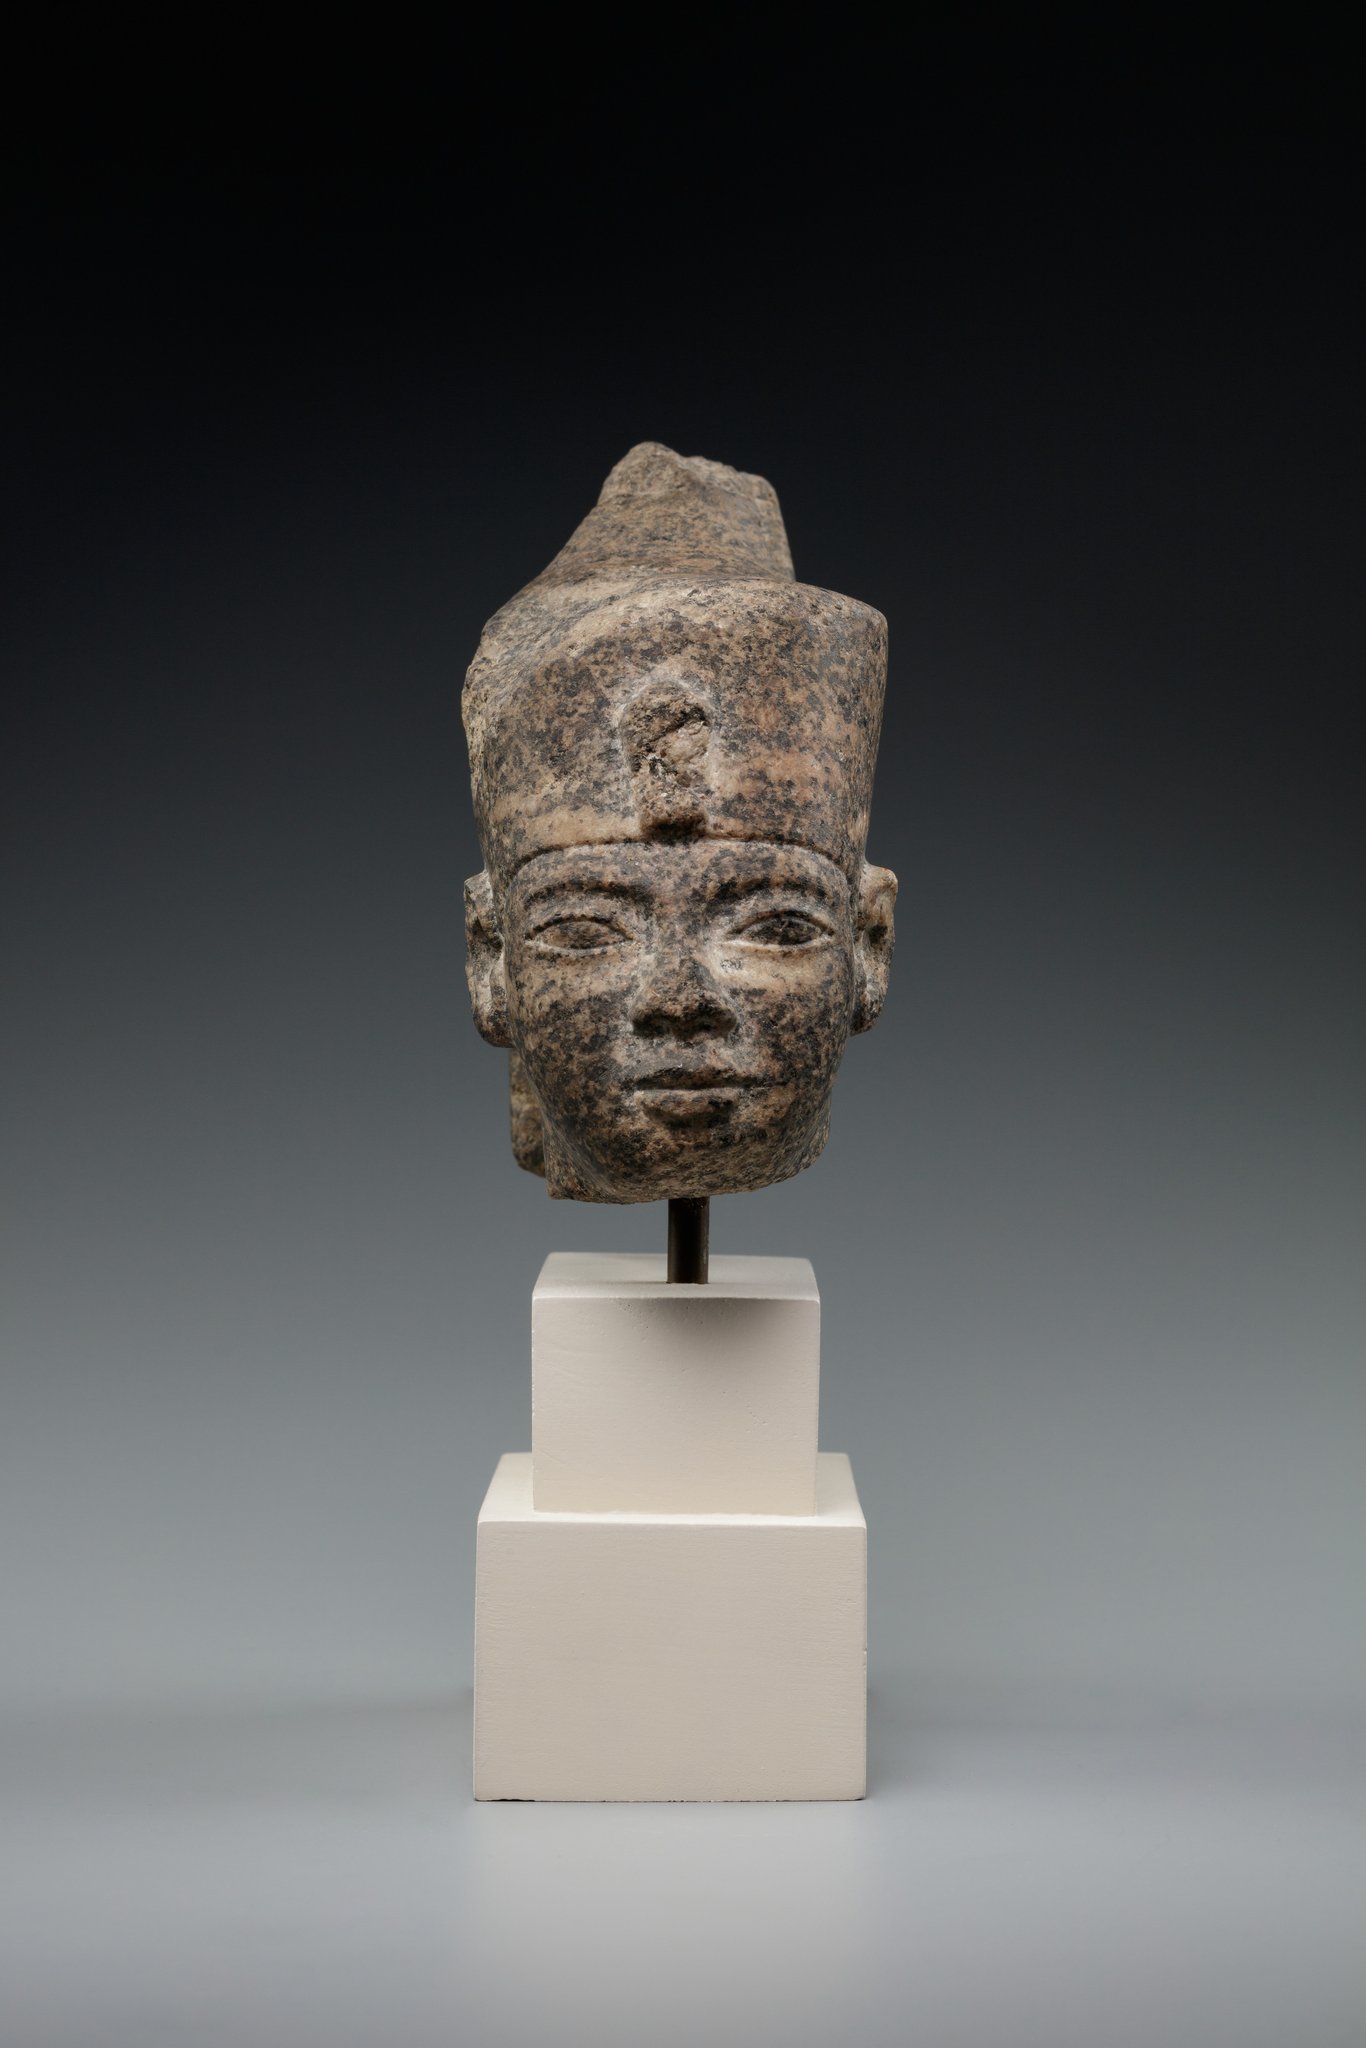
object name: head, royal, red crown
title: Head of a king in the red crown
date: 800-640 BCE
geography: egypt